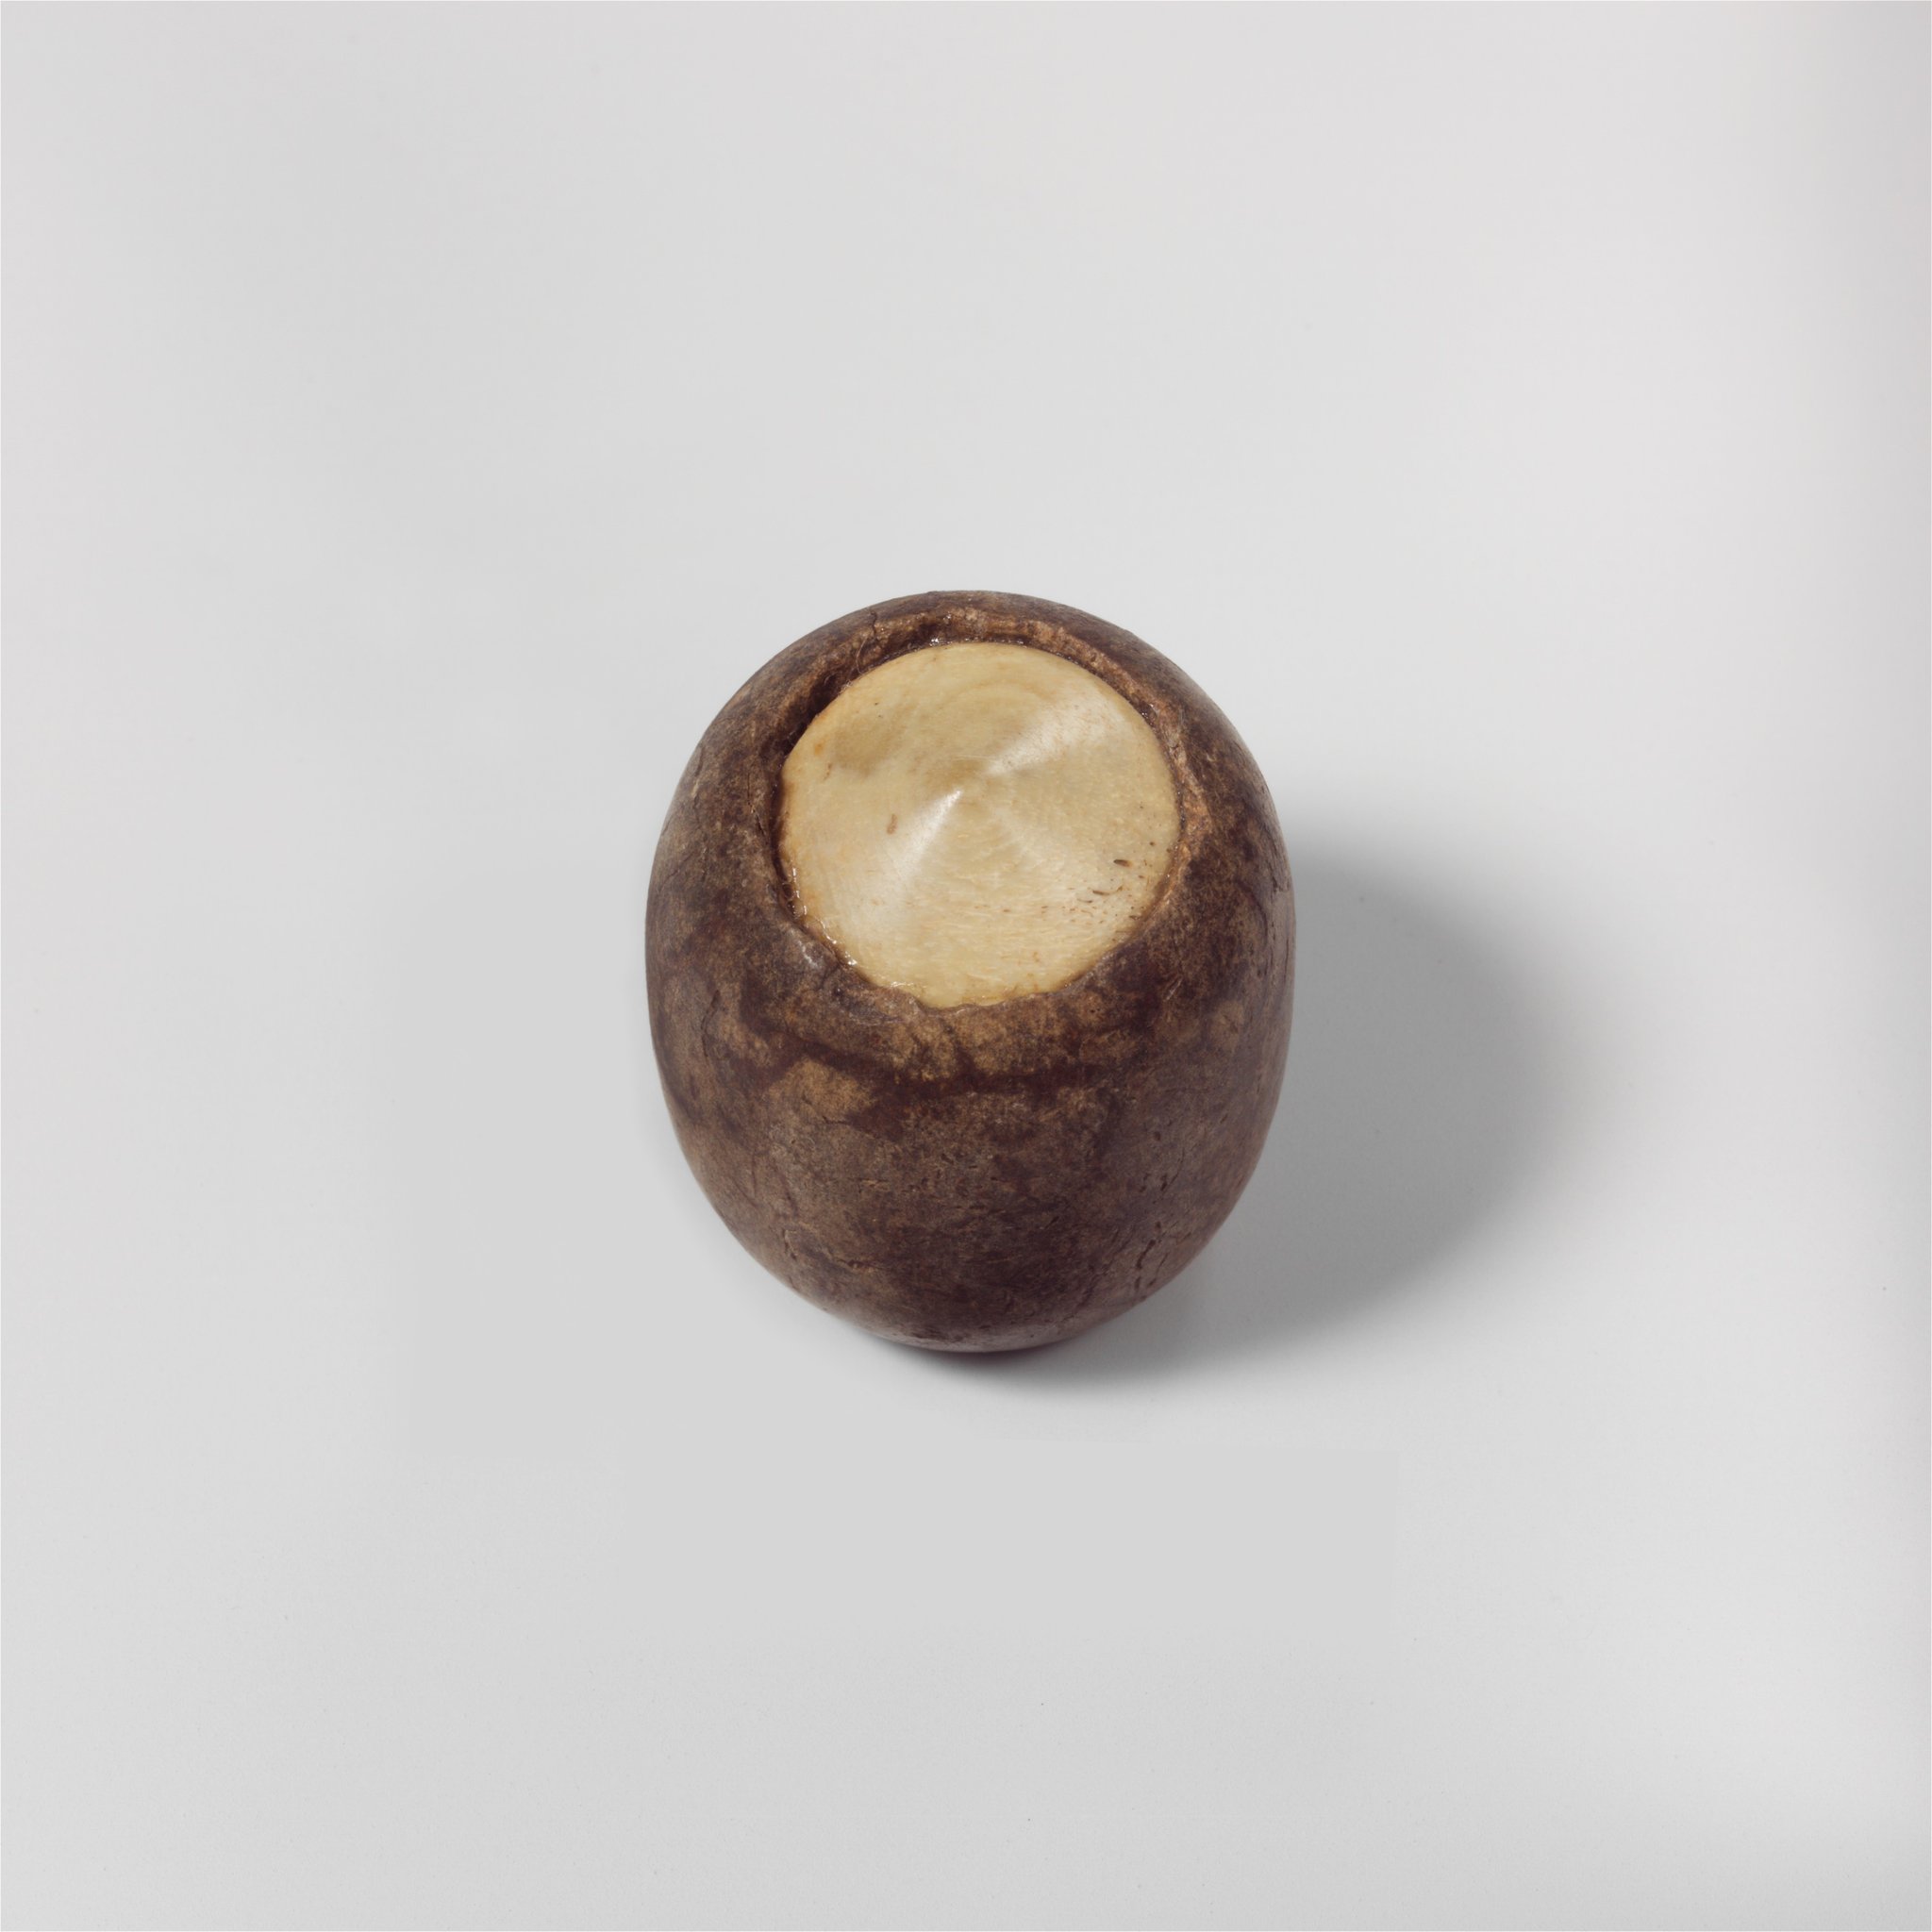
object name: die counter or draught piece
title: Bone cylinder with pointed ivory top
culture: greek, laconian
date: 700-501 BCE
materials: ivory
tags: games